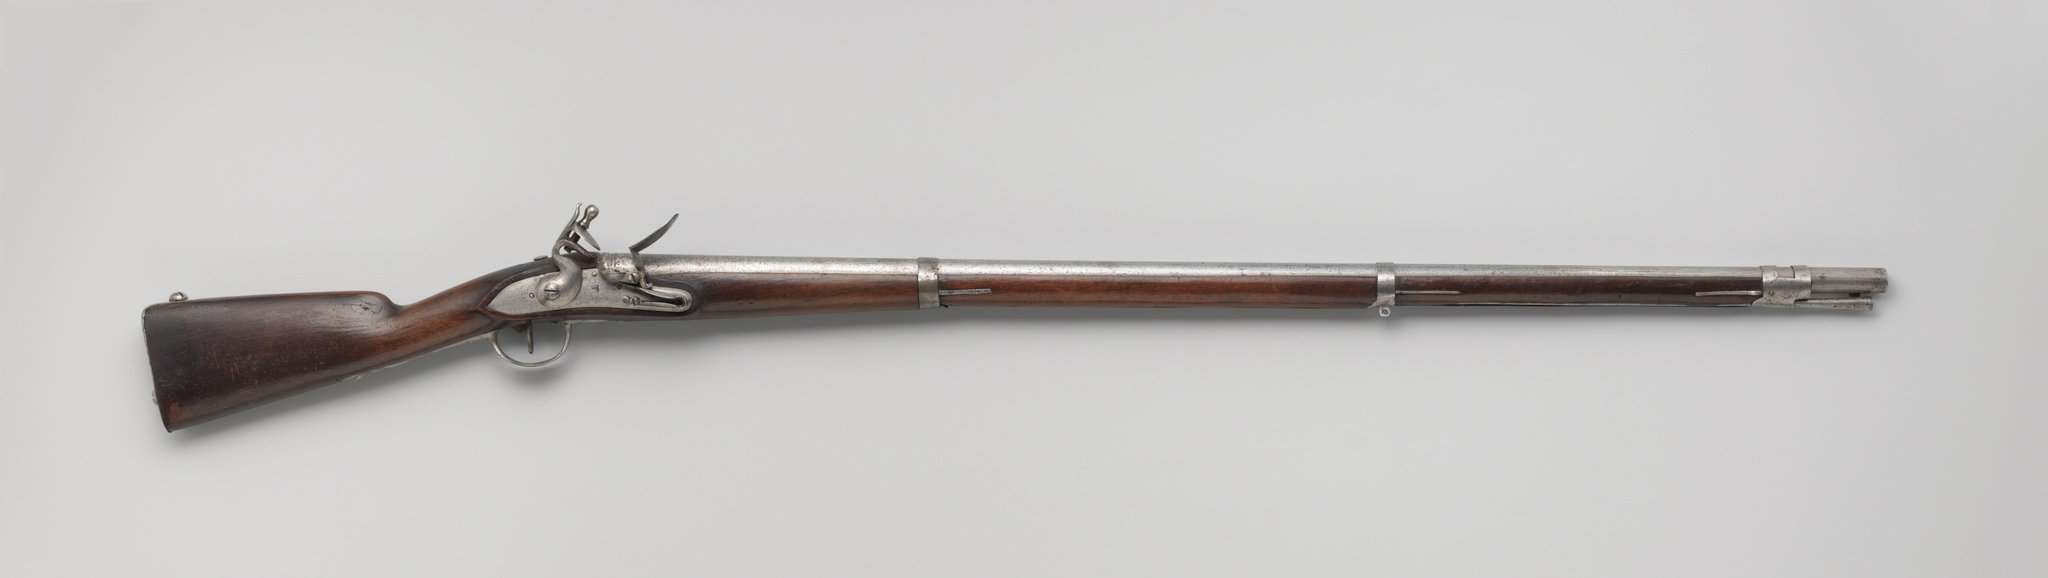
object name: flintlock pistol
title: Vuursteengeweer voor het Staatse leger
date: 1770-1780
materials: iron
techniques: printing, cutting, painting, soldering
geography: culemborg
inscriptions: : ‘PR75:48’, coat of arms: ‘wapen van Culemborg (H/St. 8618, 8619)’, inscription: ‘GENERALITEIT’